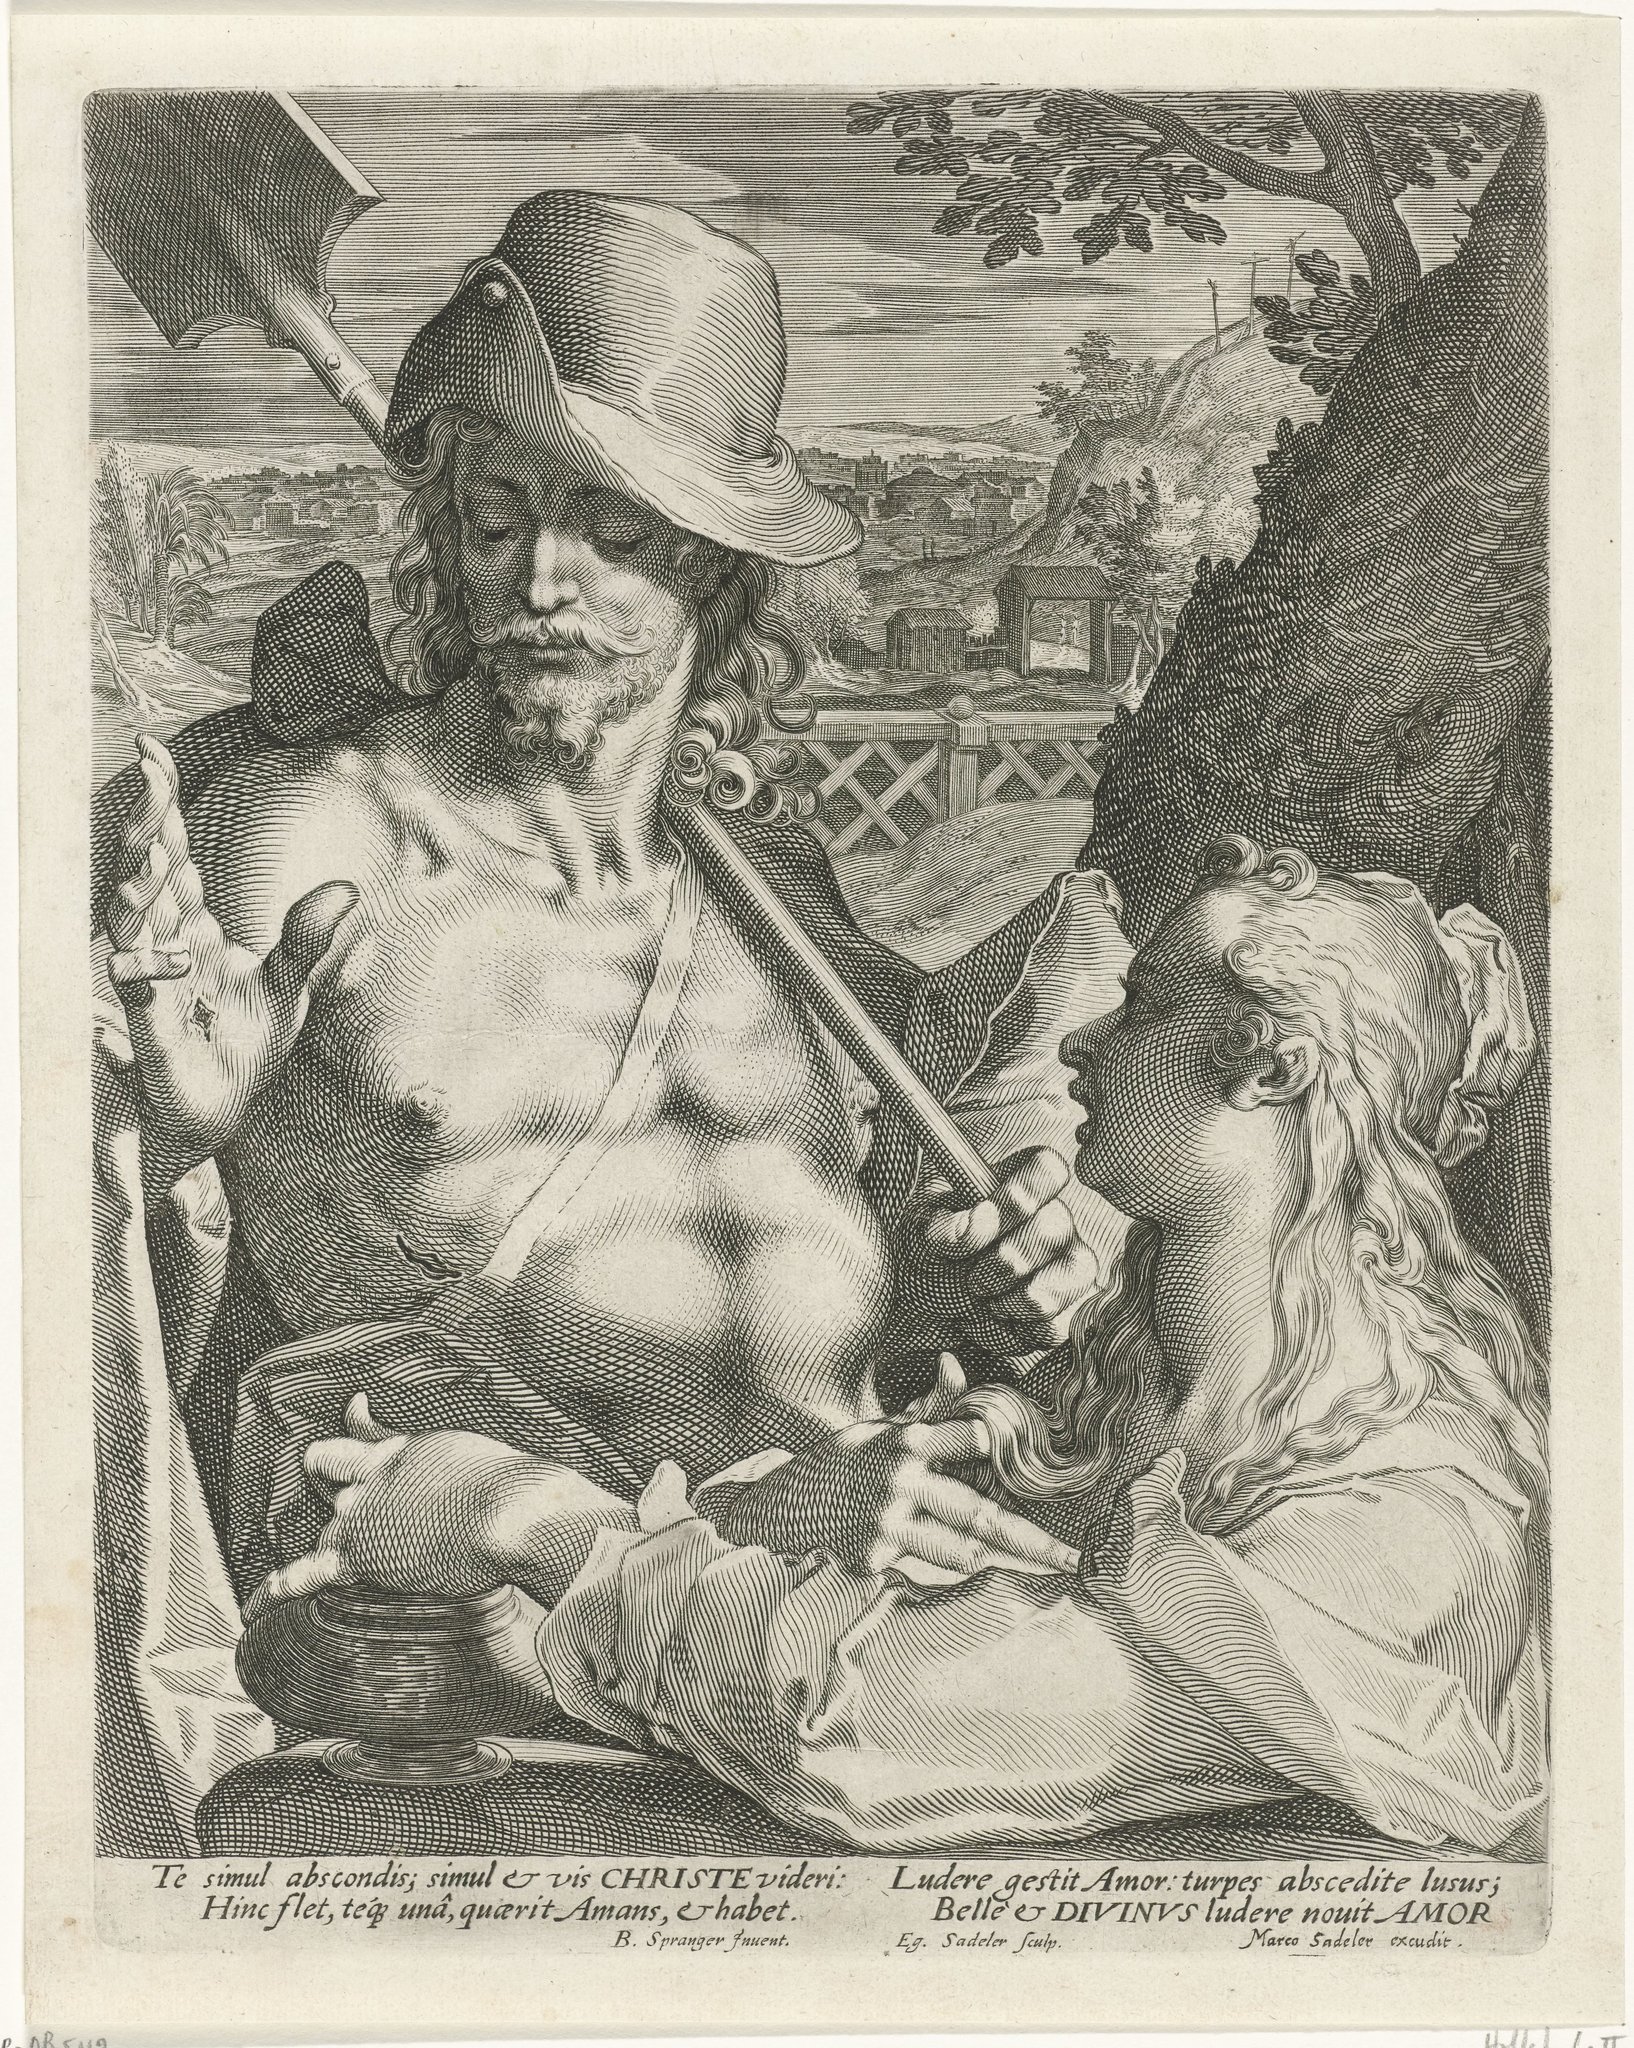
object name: print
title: Christus verschijnt als tuinman aan Maria Magdalena (Noli mi tangere)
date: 1580-1629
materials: paper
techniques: engraving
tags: mary magdalene kneeling before christ, who is usually represented as a gardener with a hoe and/or a spade; 'noli me tangere'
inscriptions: collector's mark: Lugt 240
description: De verrezen Christus verschijnt aan Maria Magdalena in de gedaante van een tuinman. Zijn kruiswonden zijn zichtbaar. Maria Magdalena heeft een zalfpot in de hand. De prent heeft een Latijns onderschrift.